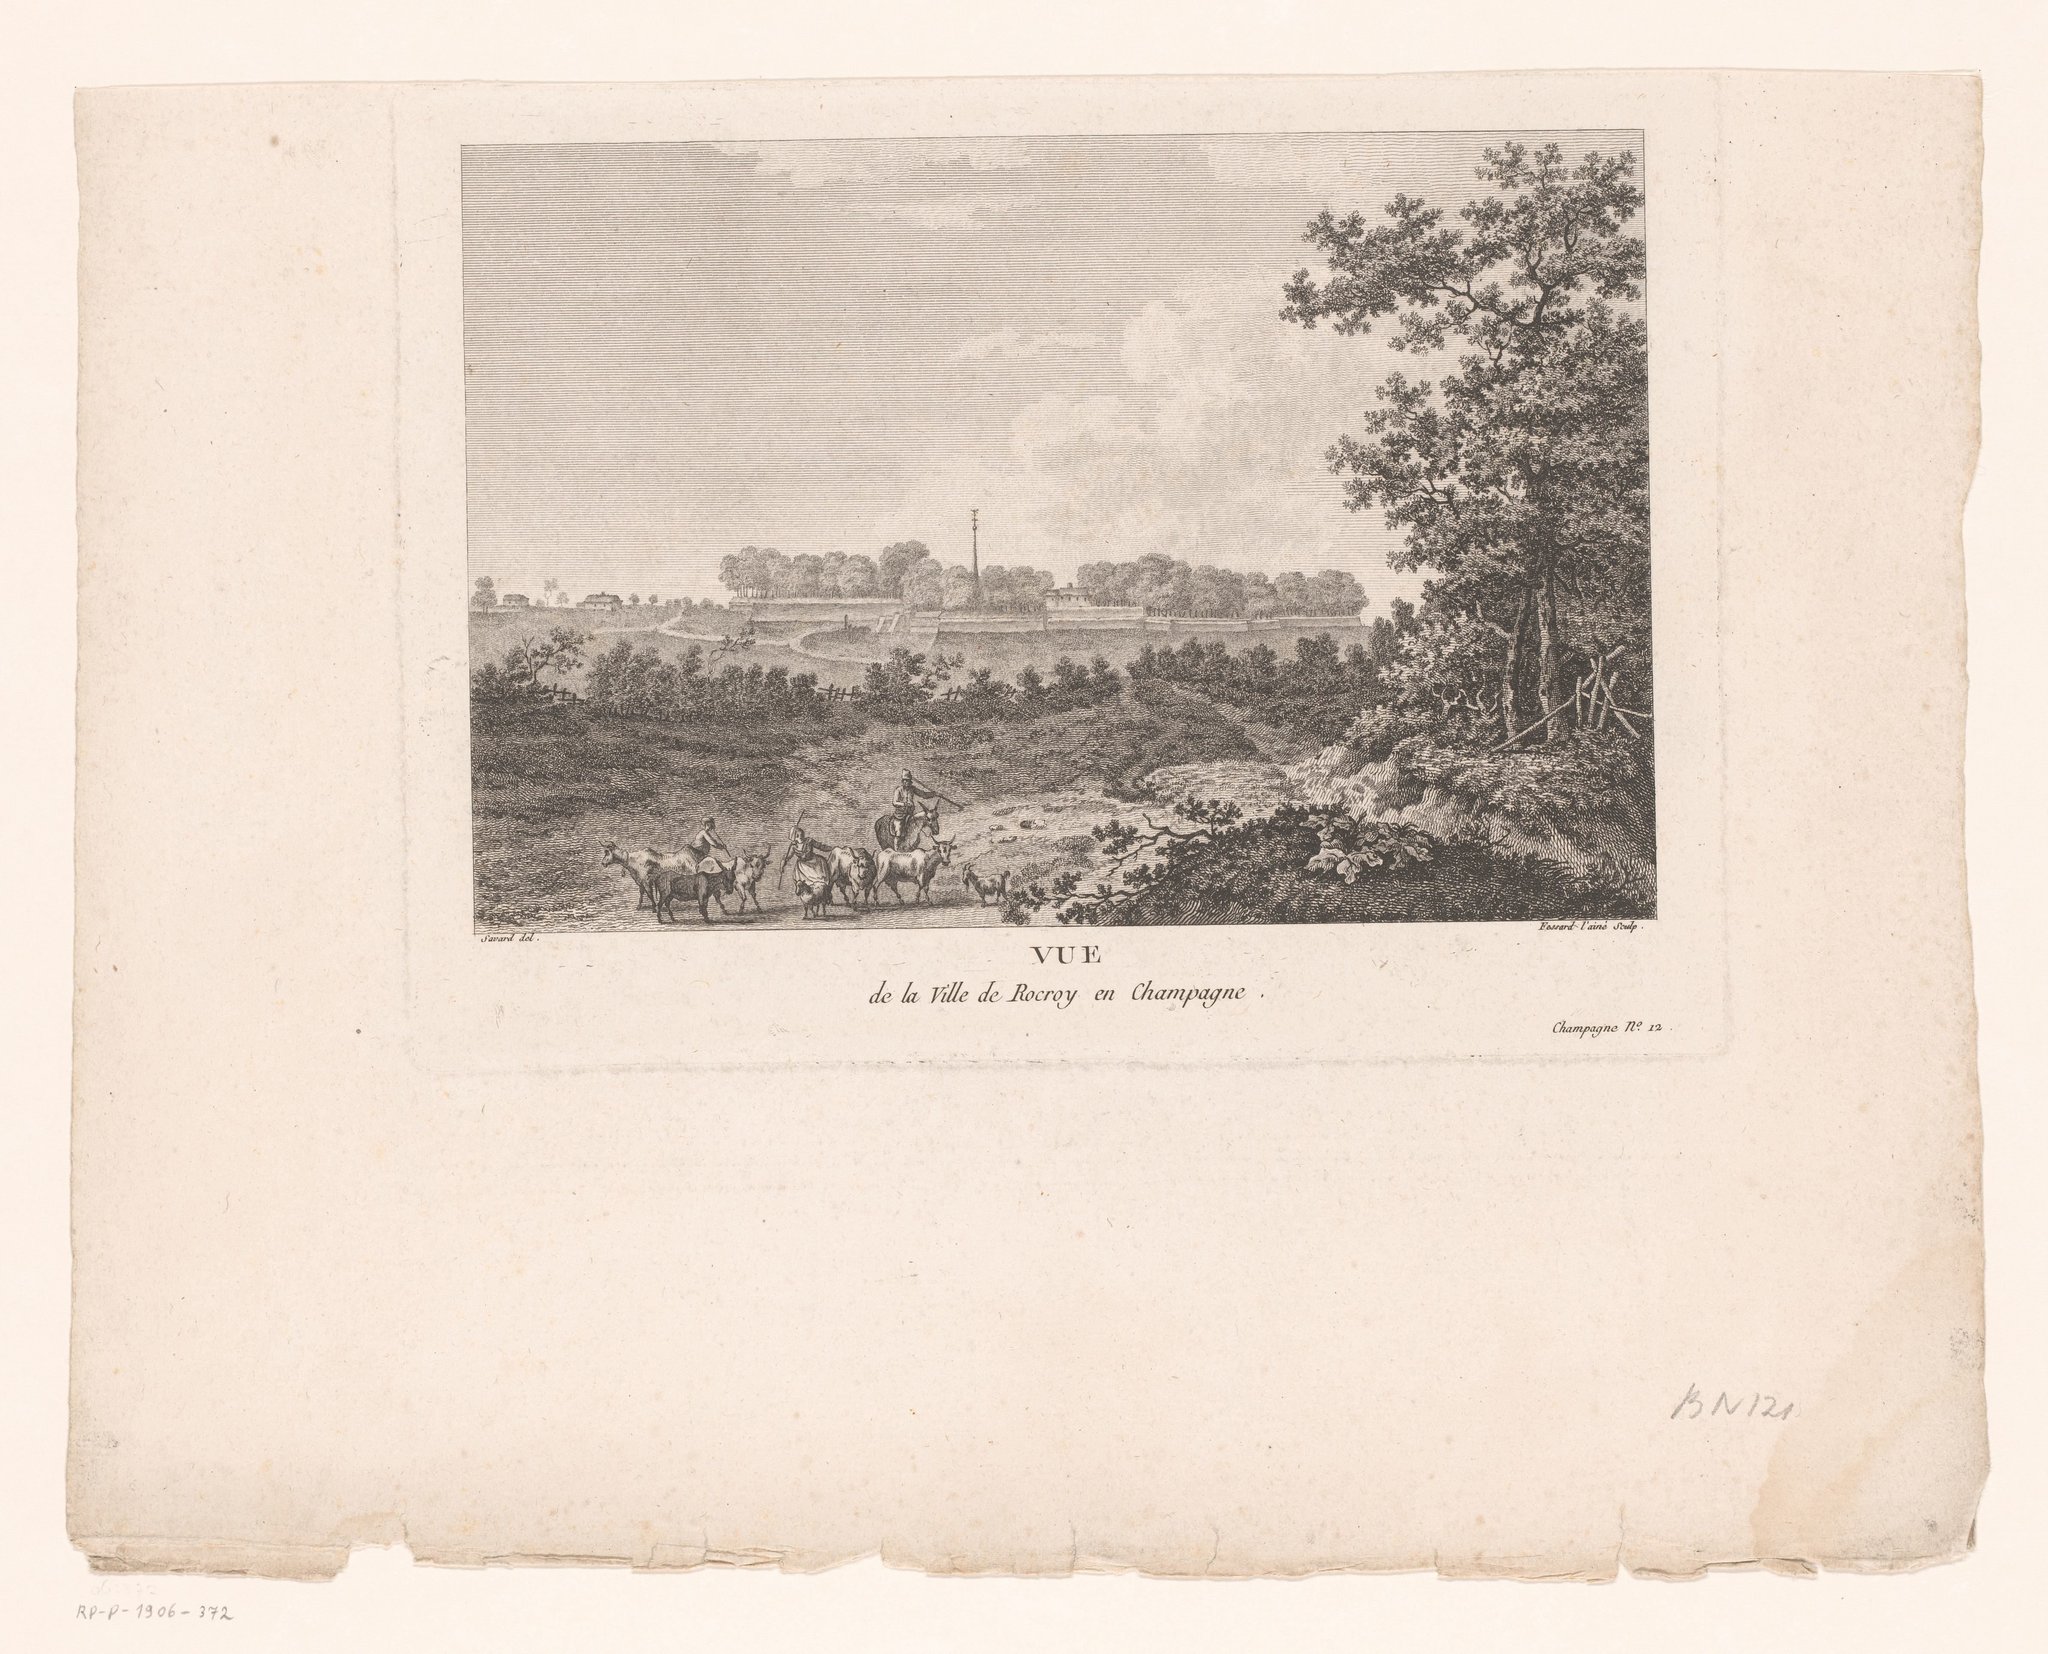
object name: book illustration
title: Vue de la Ville de Rocroy en Champagne.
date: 1781-1796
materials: paper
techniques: etching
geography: france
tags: herd, flock, prospect of city, town panorama, silhouette of city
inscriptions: collector's mark: Lugt 2228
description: Prent uit: Une Société de gens de lettres. Voyage pittoresque de la France : avec la description de toutes ses provinces (...). Parijs: Pierre-Michel Lamy, 1781-1796, dl. 6.